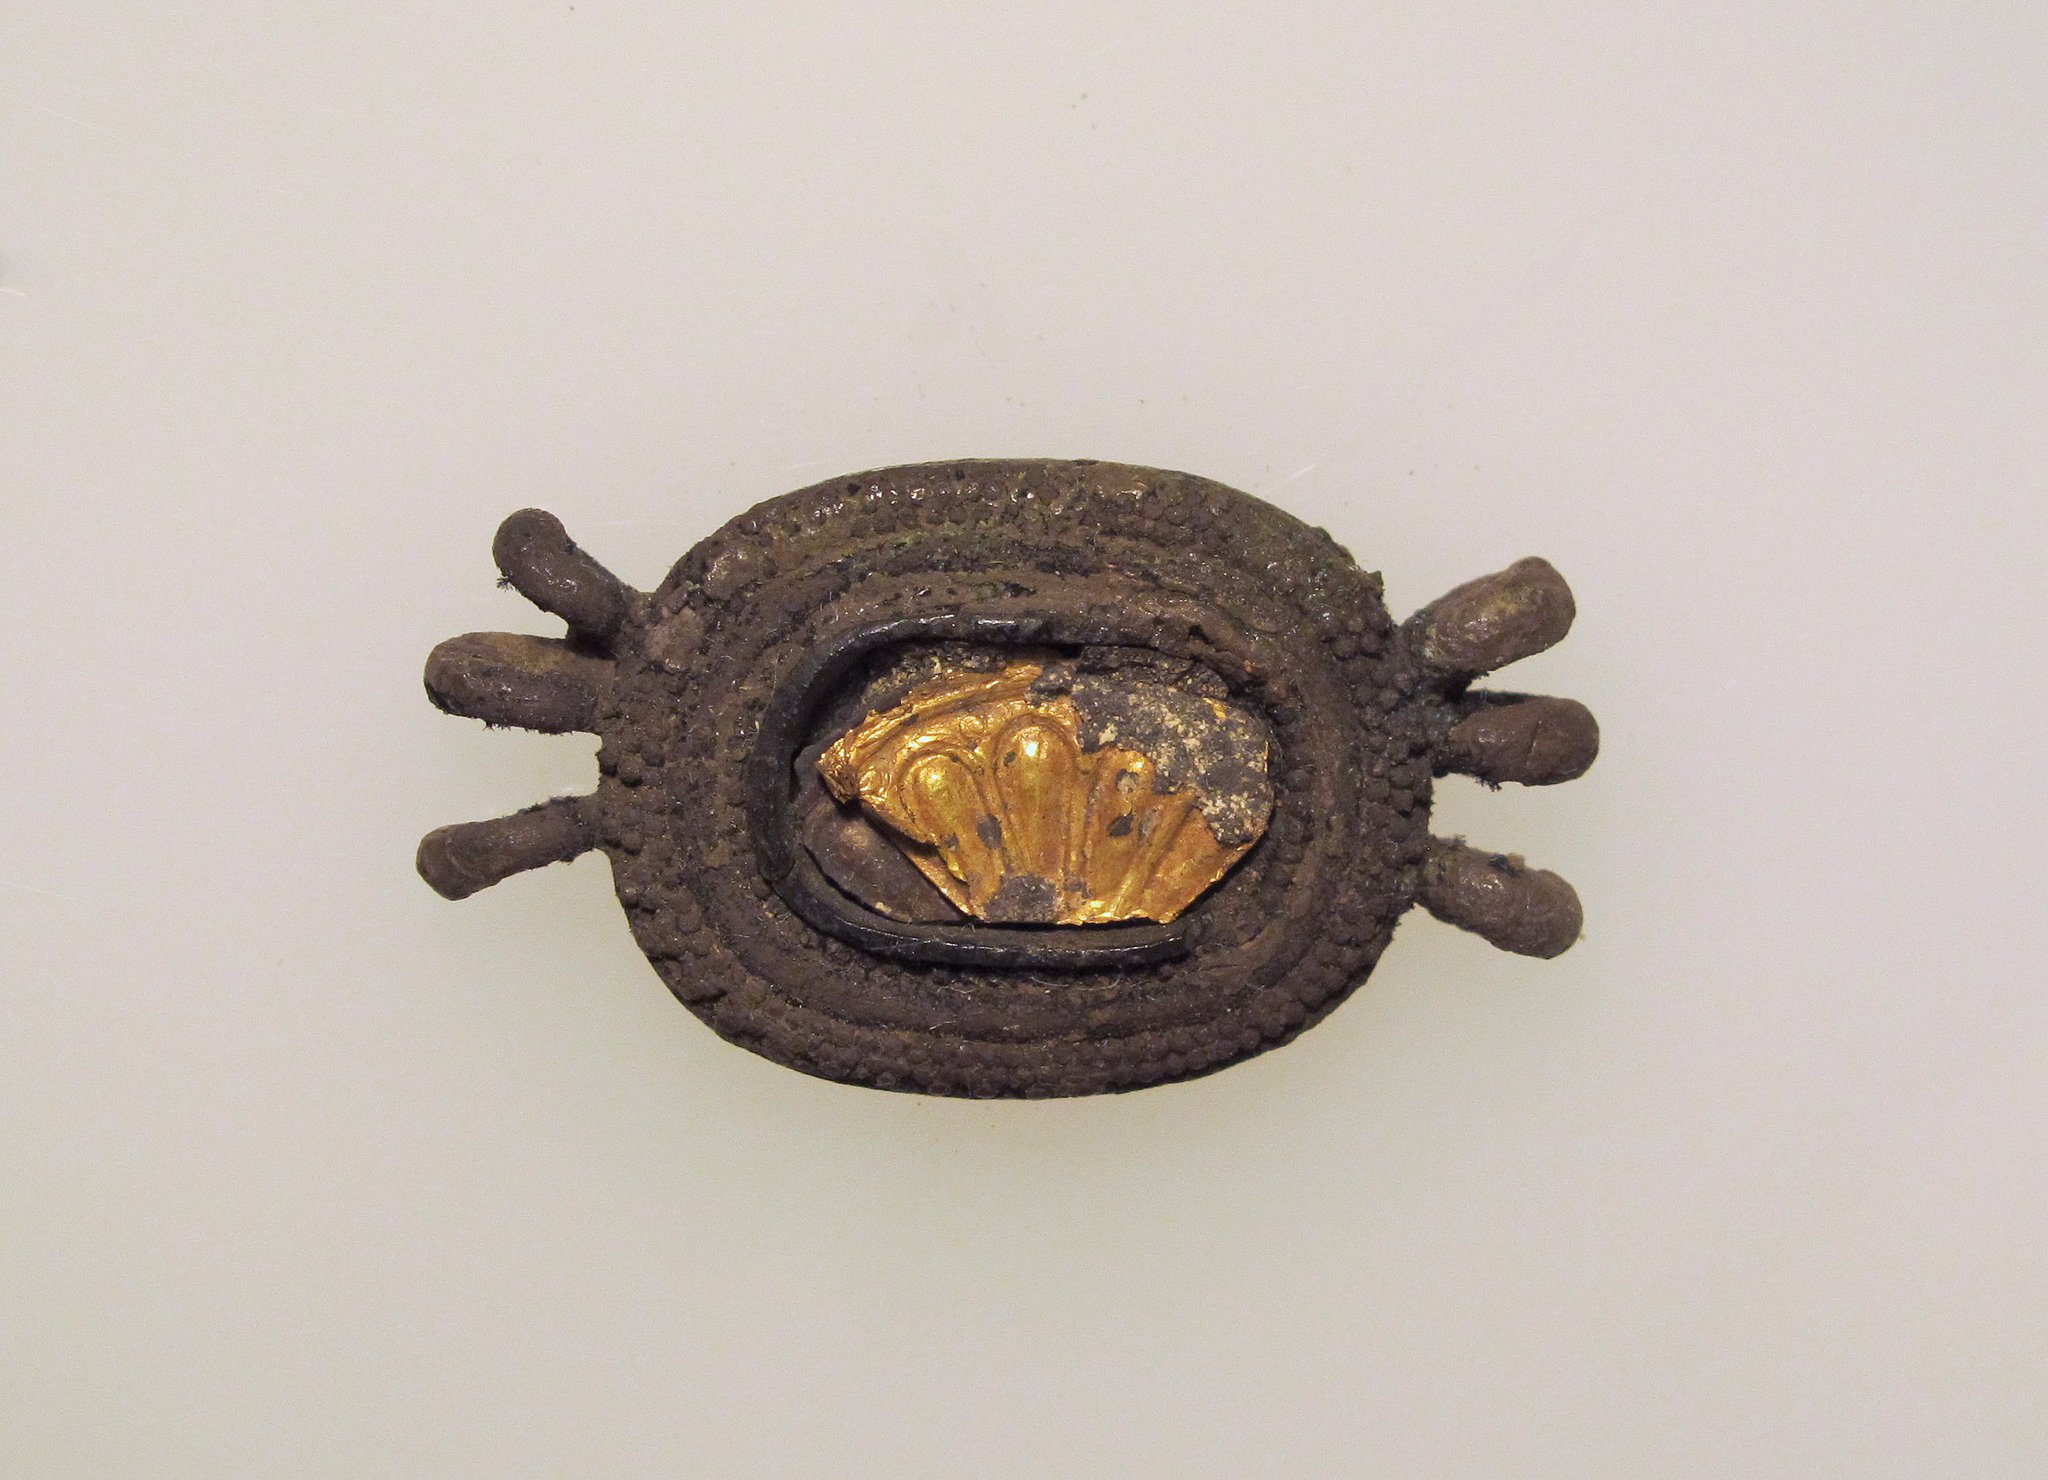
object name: bead, control plaque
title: Silver bead, control plaque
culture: cypriot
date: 3900 BCE-100 CE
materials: silver